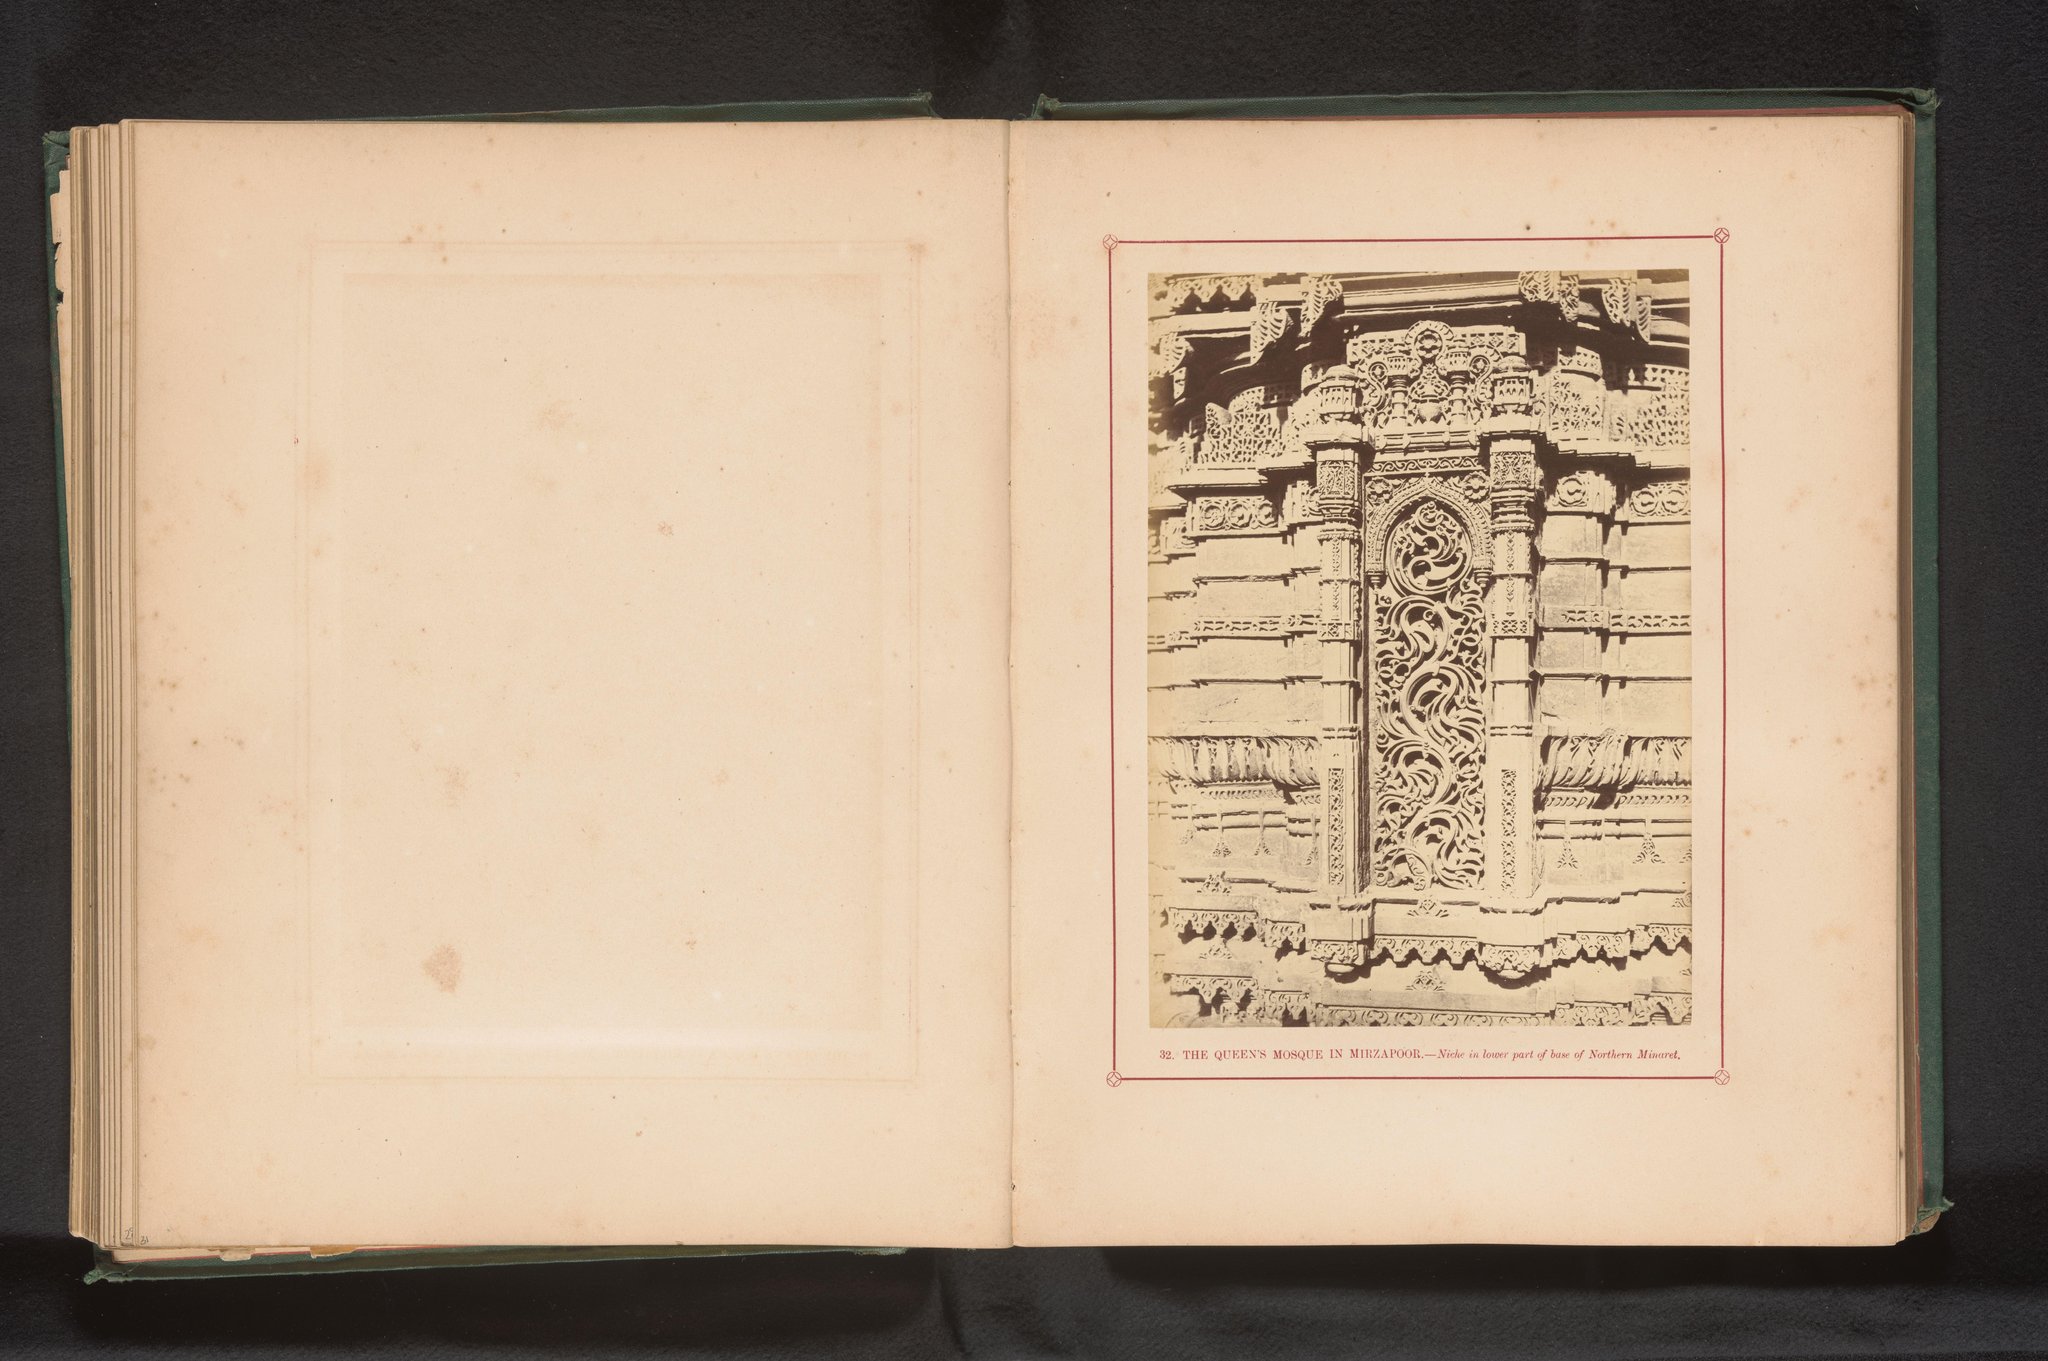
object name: photograph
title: The Queen's Mosque in Mirzapoor.- Niche in lower part of base of Northern Minaret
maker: thomas biggs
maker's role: fotograaf, kapitein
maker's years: 1822-1905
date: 1856-1866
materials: photographic support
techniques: albumen print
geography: ahmedabad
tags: temple, shrine ~ islam, mohammedanism, base (~ column, pillar), ornamenting, decorating ~ applied arts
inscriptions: number: ‘32.’